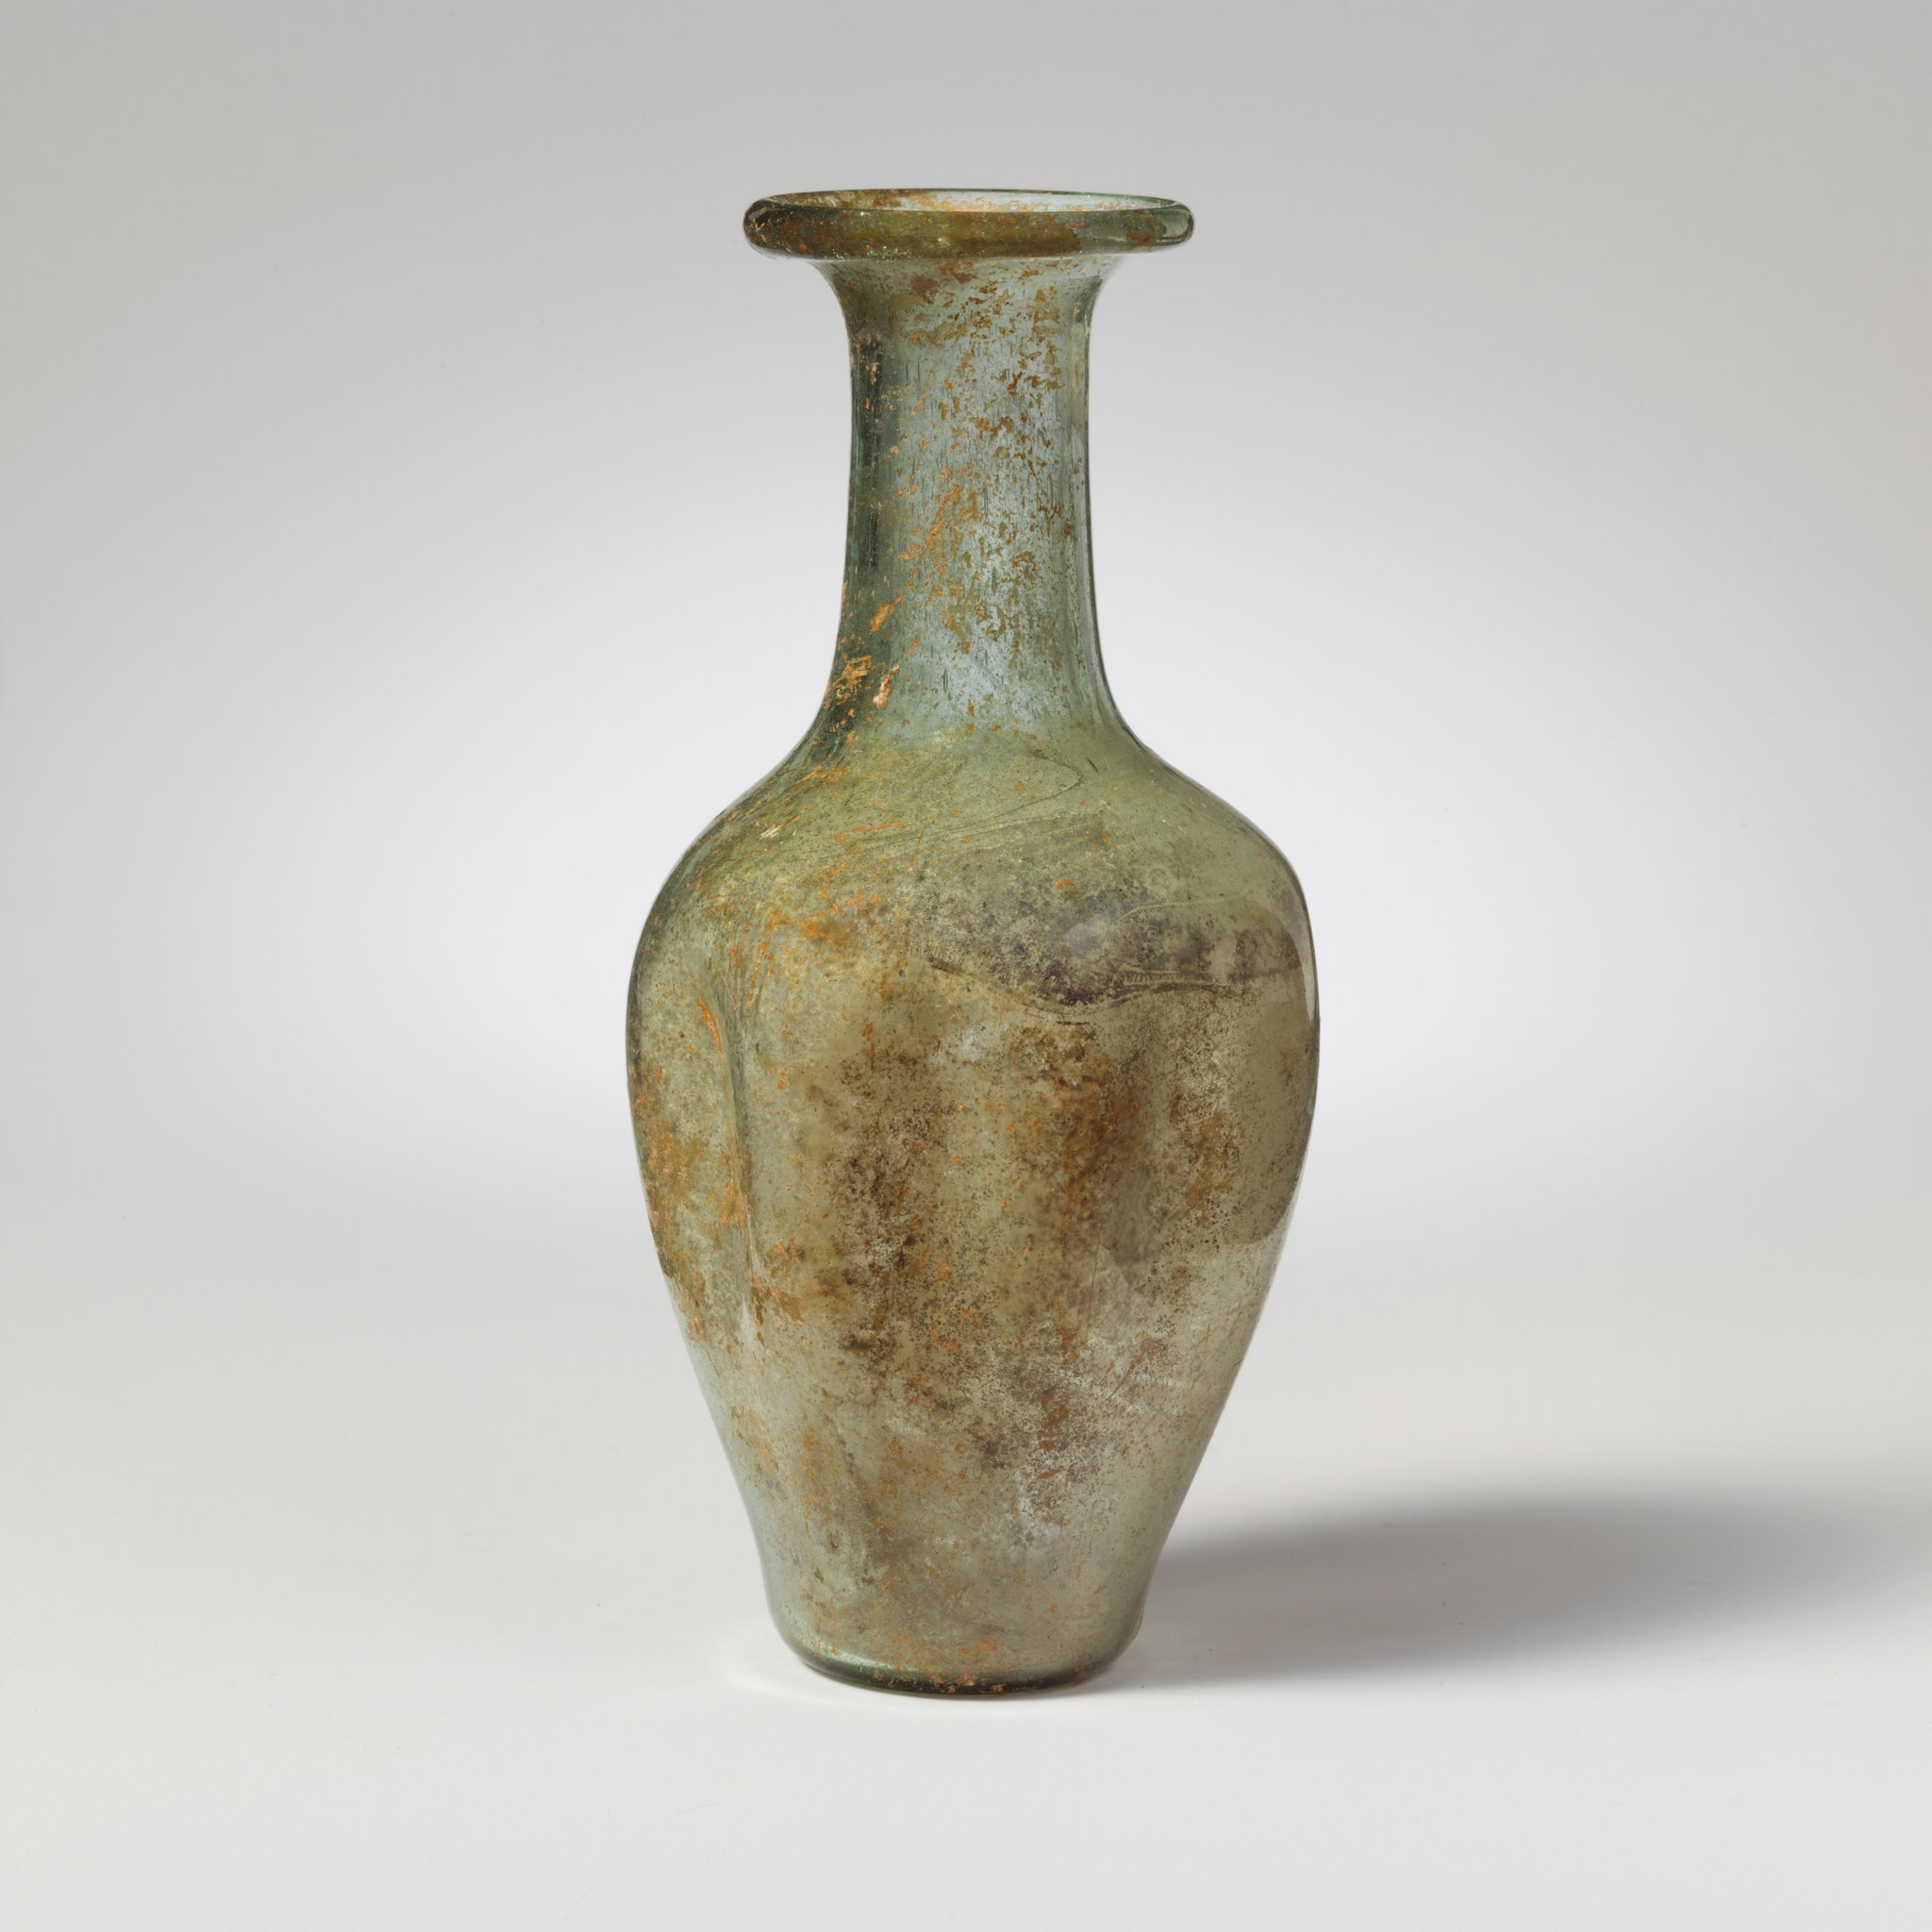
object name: flask, indented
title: Glass flask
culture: roman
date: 101-300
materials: glass